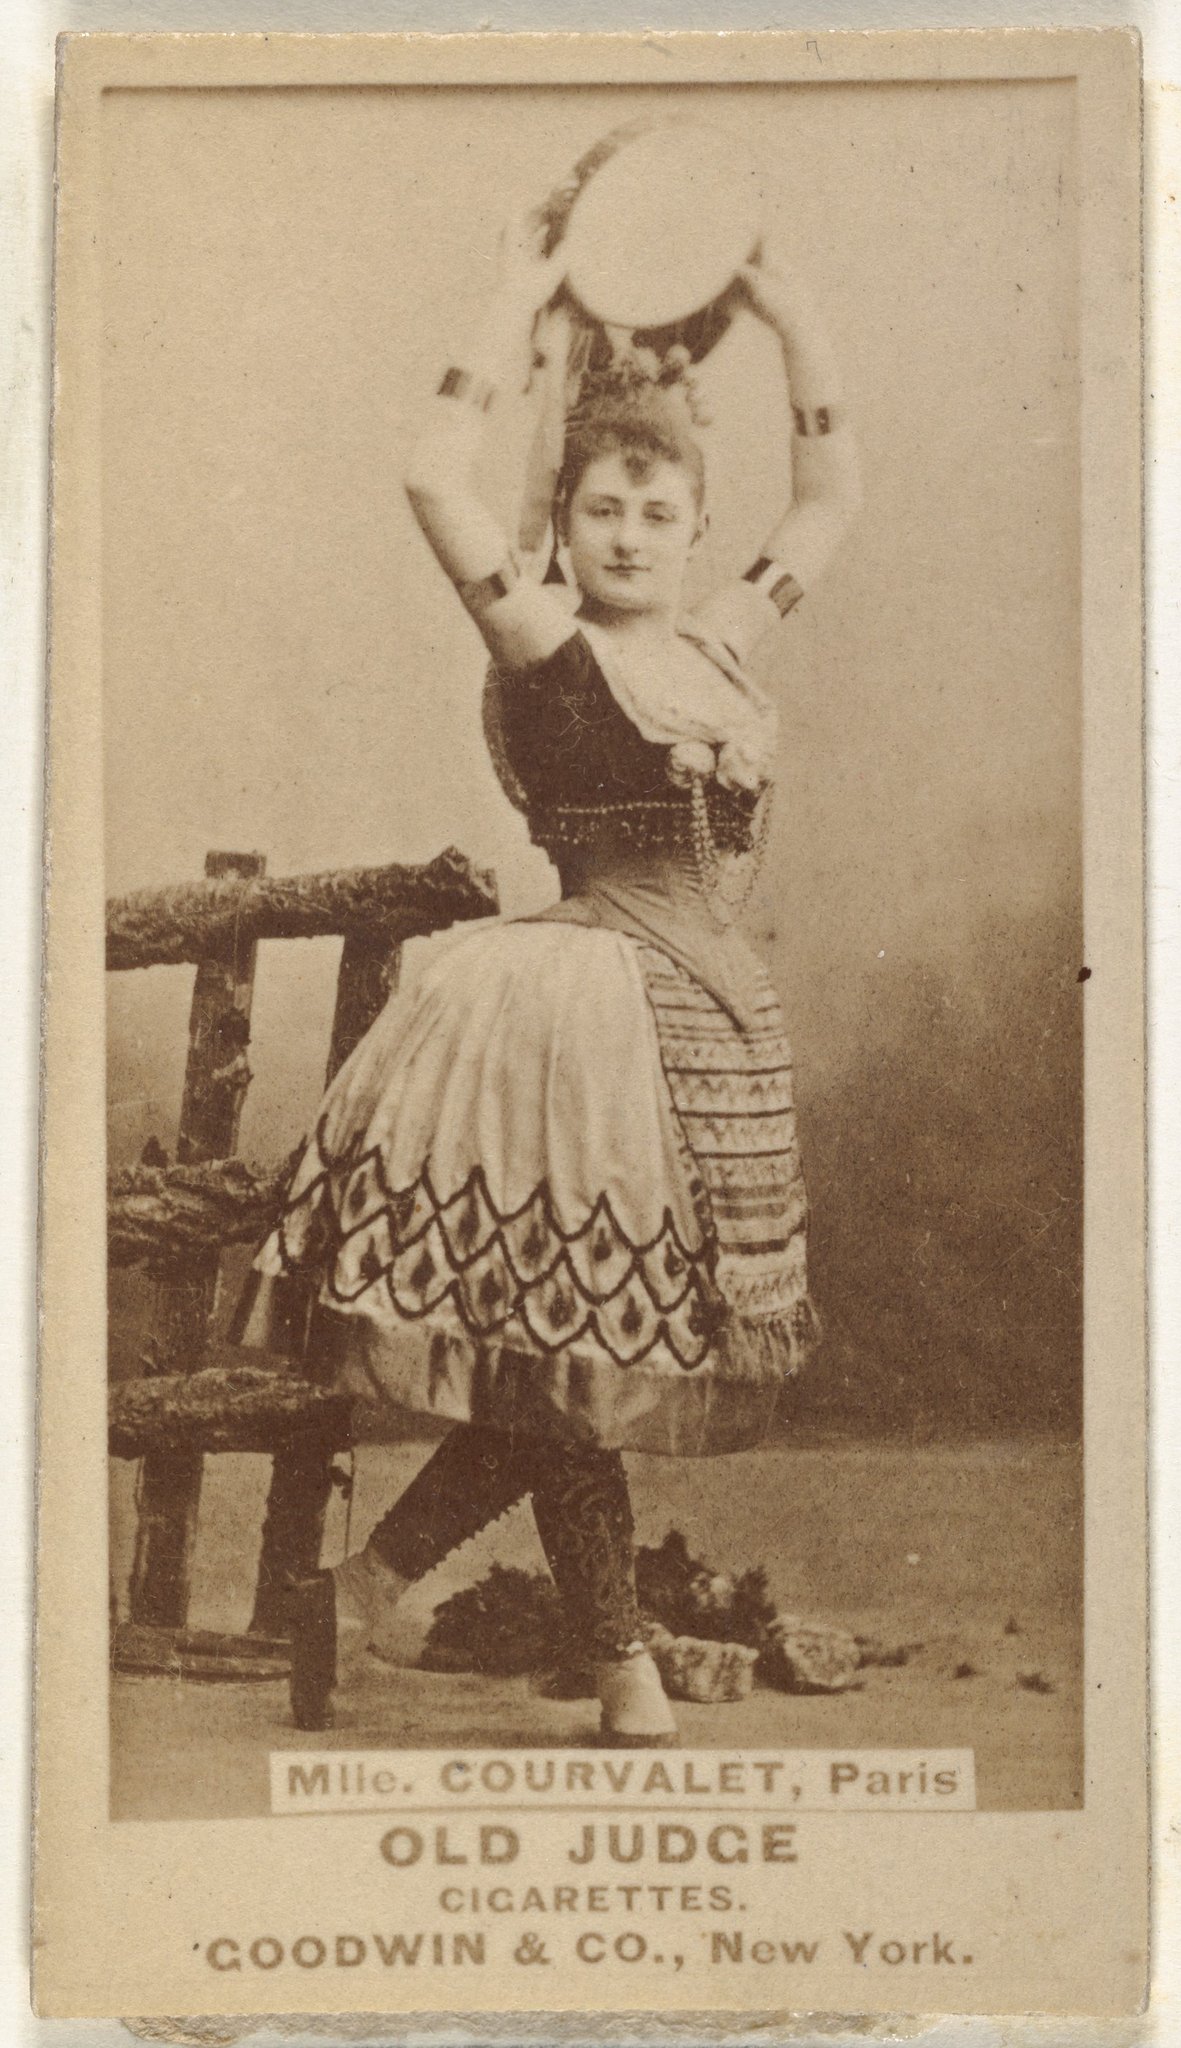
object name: photograph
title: Mlle. Courvalet, Paris, from the Actors and Actresses series (N171) for Old Judge Cigarettes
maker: goodwin & company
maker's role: publisher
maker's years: 1850-1950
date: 1886-1890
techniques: albumen silver print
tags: portraits,women,actresses